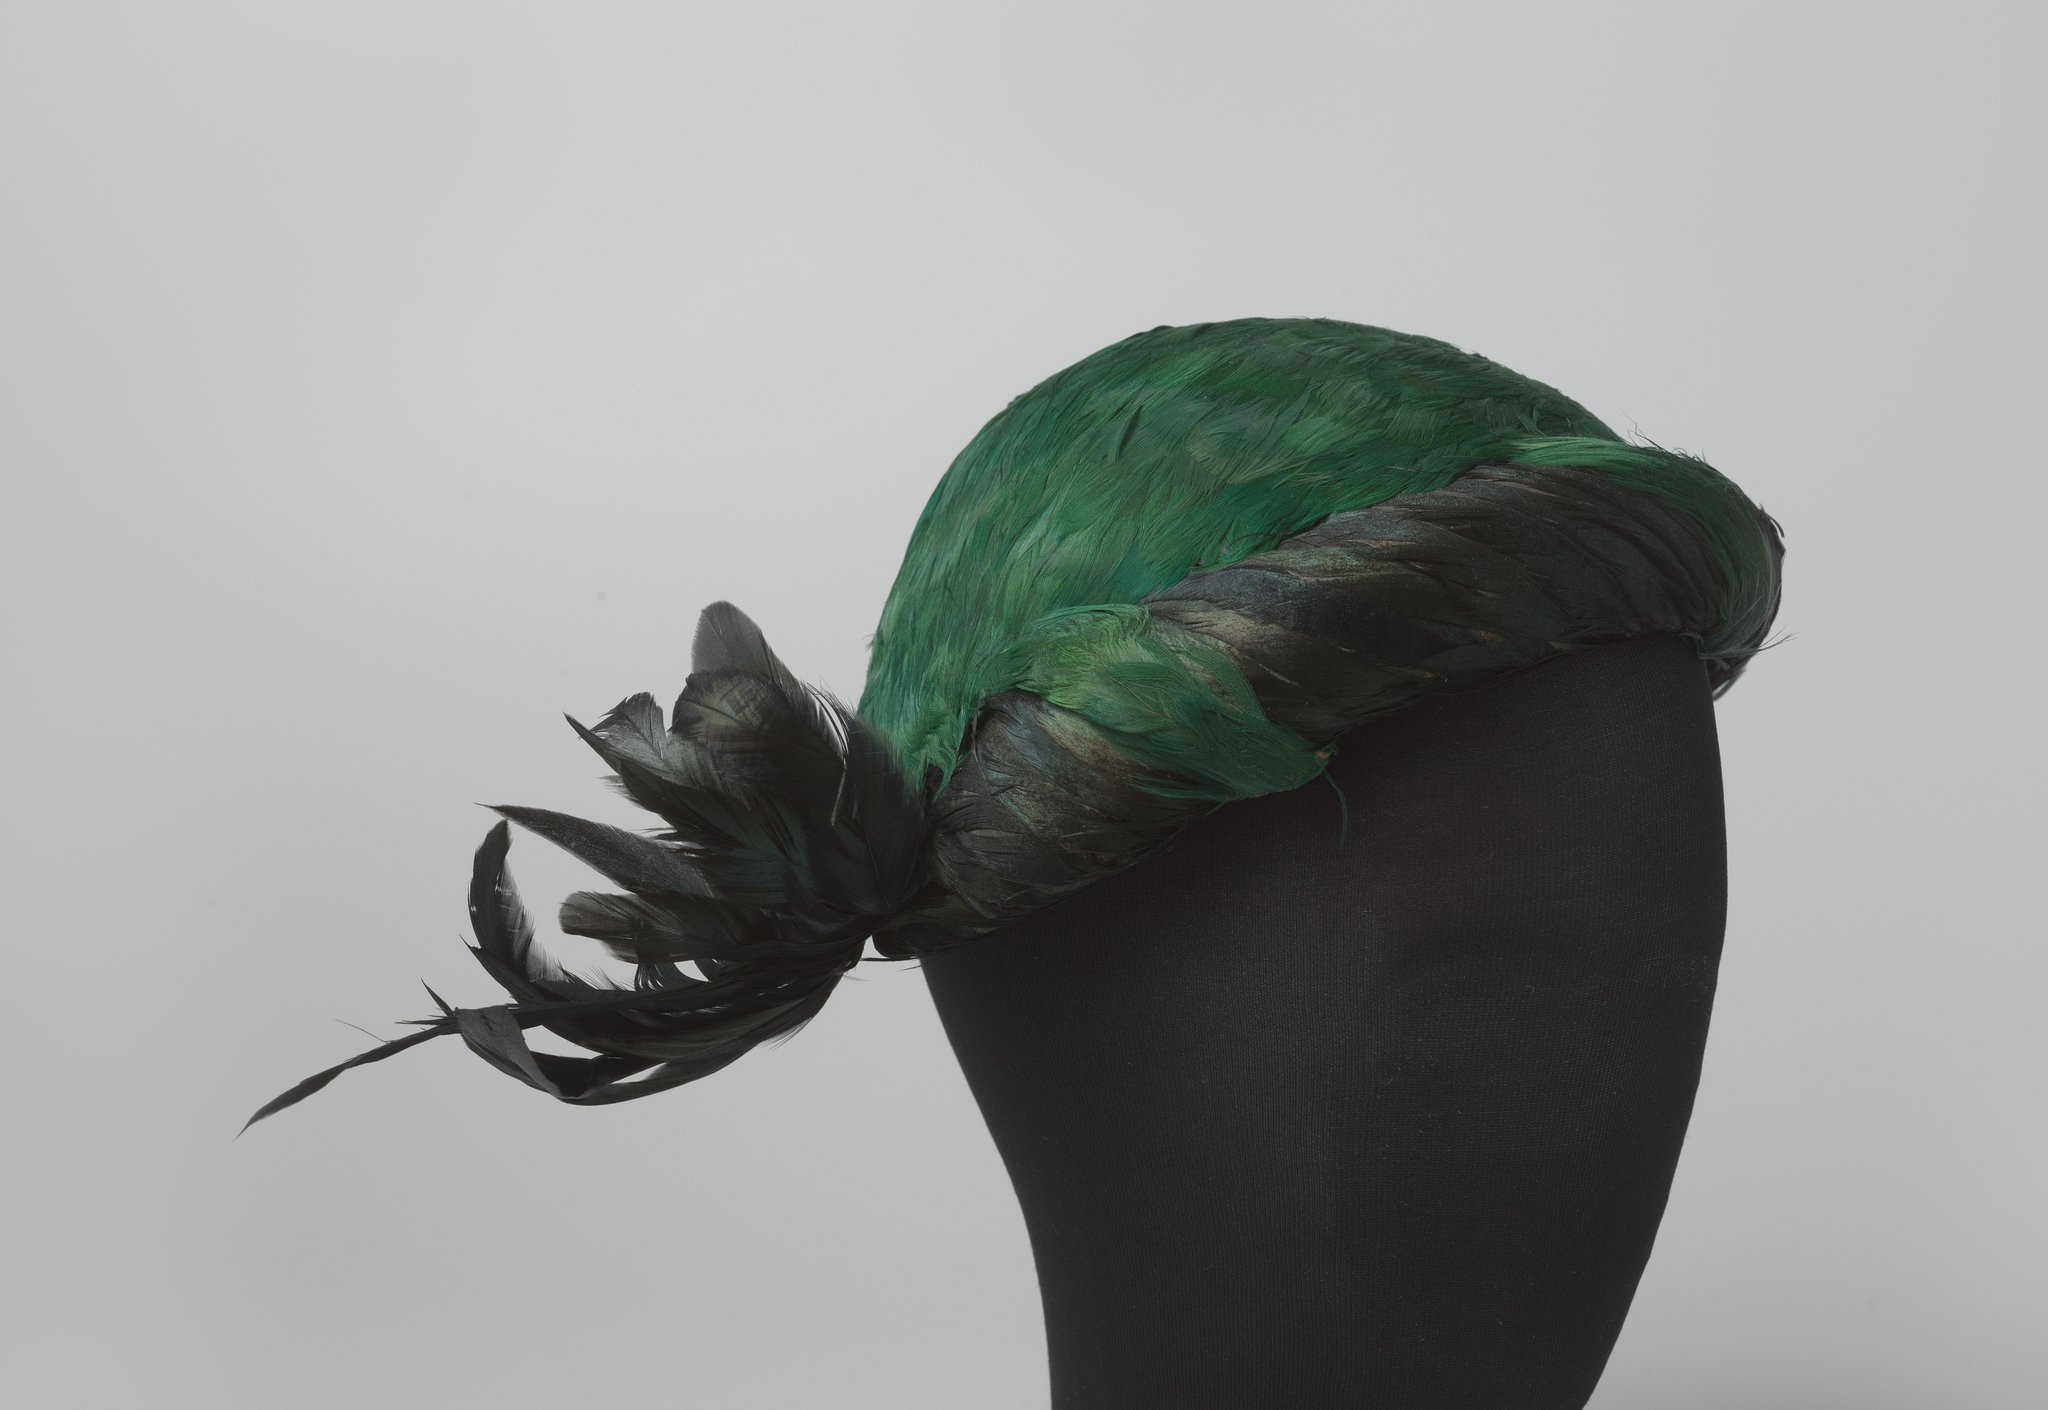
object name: headcap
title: Kapje met groene en zwarte veren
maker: Anonymous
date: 1948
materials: feather, textile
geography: england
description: Ronde hoed met groene en zwarte veren. Uit de rand steekt een pluim van zwarte veren.